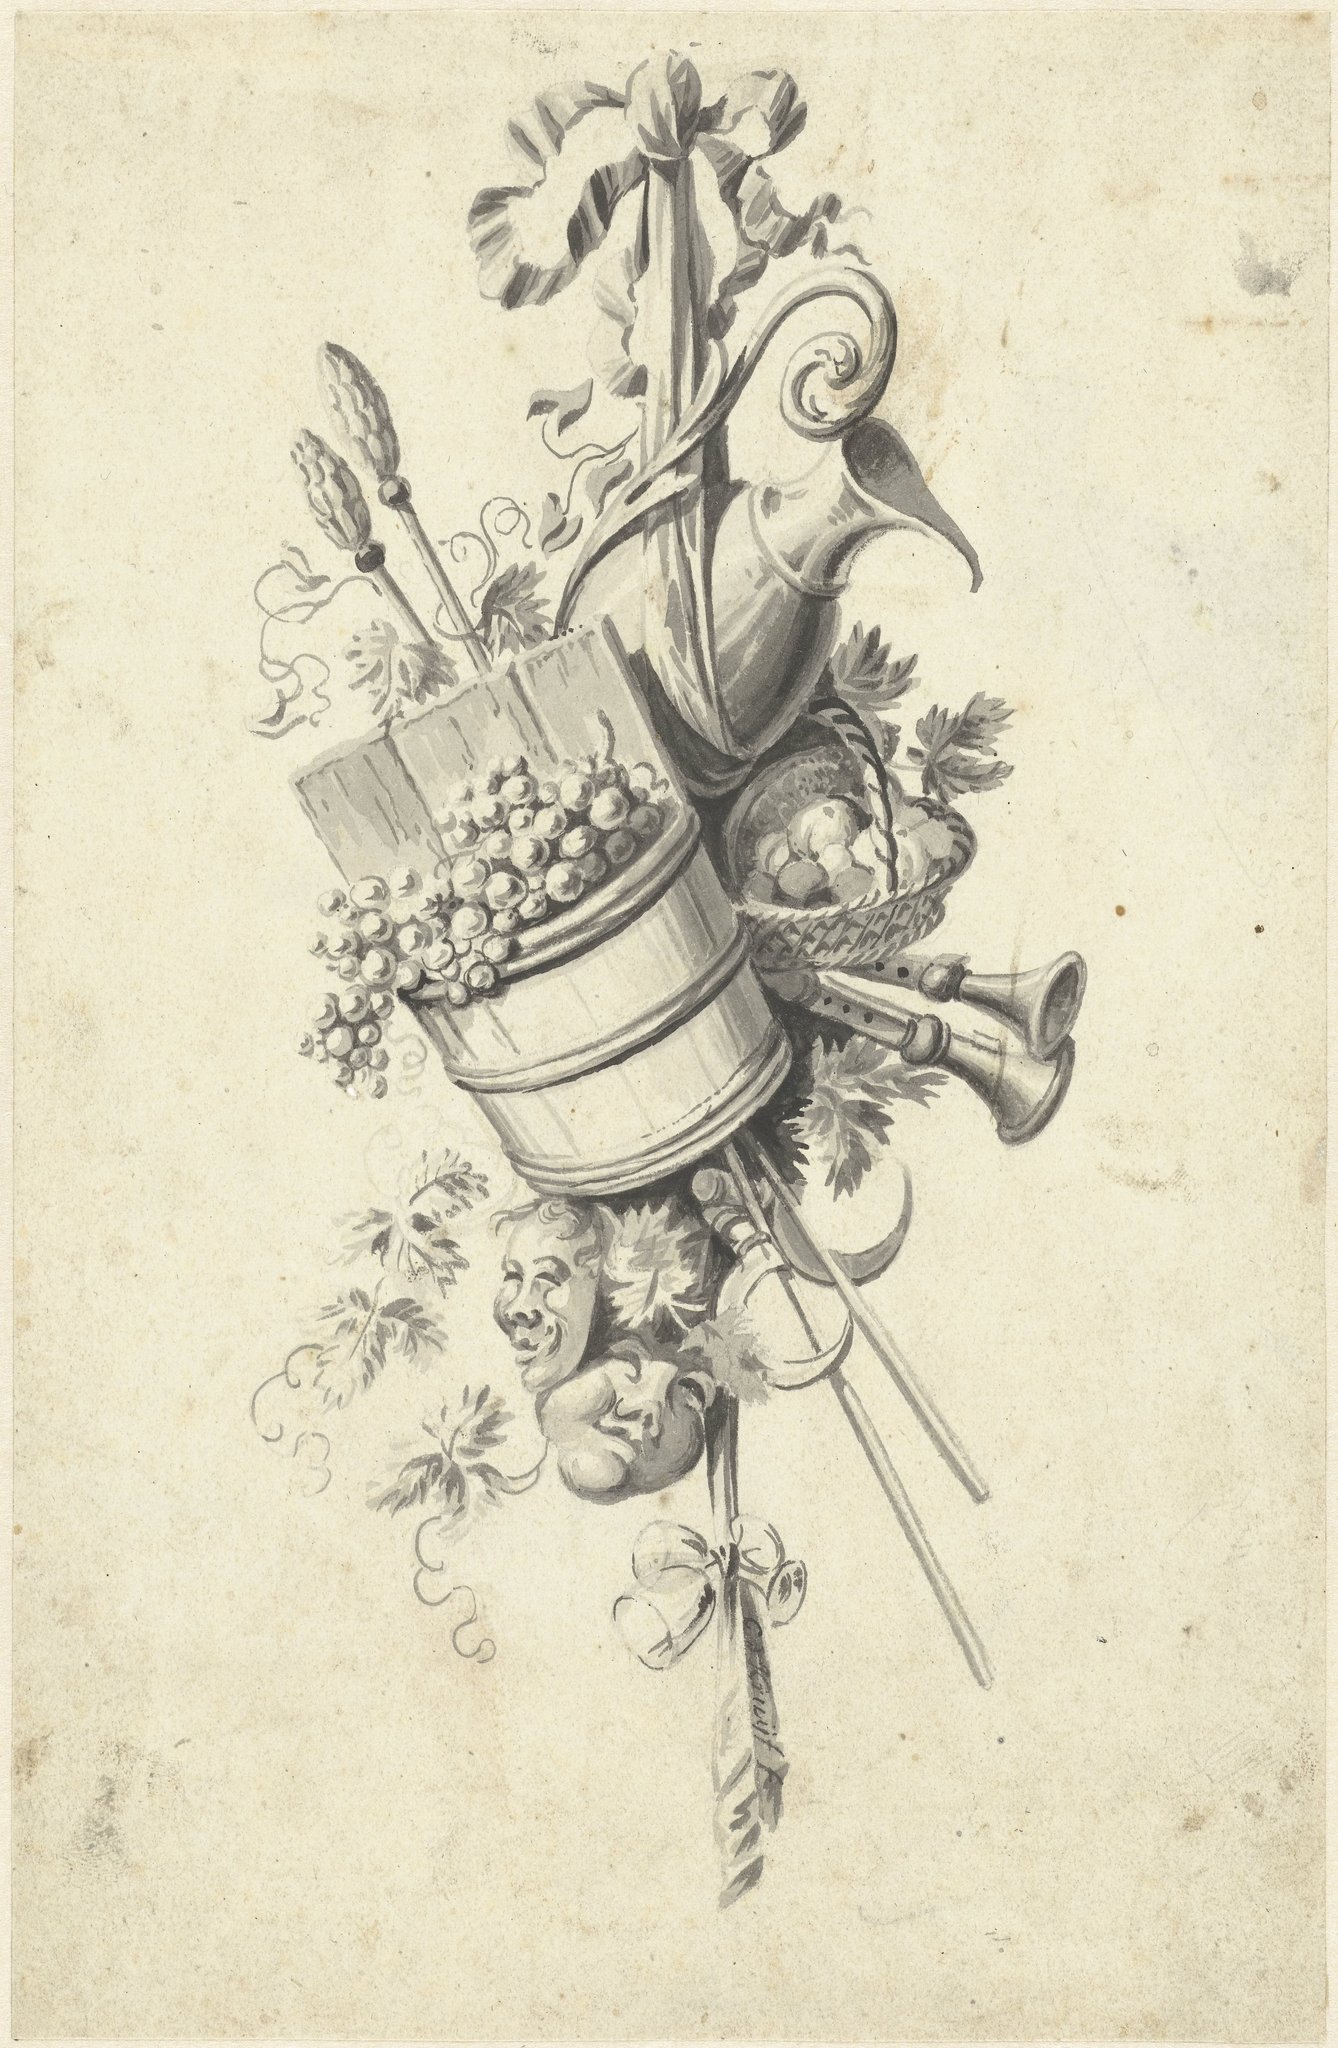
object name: drawing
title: Trofee met attributen van de wijnoogst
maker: cornelis de kruyff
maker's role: draughtsman, print maker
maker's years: 1774-1828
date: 1784-1828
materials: ink, paper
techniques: brush, pen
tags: ornament derived from objects, viticulture, wine-growing; vintage